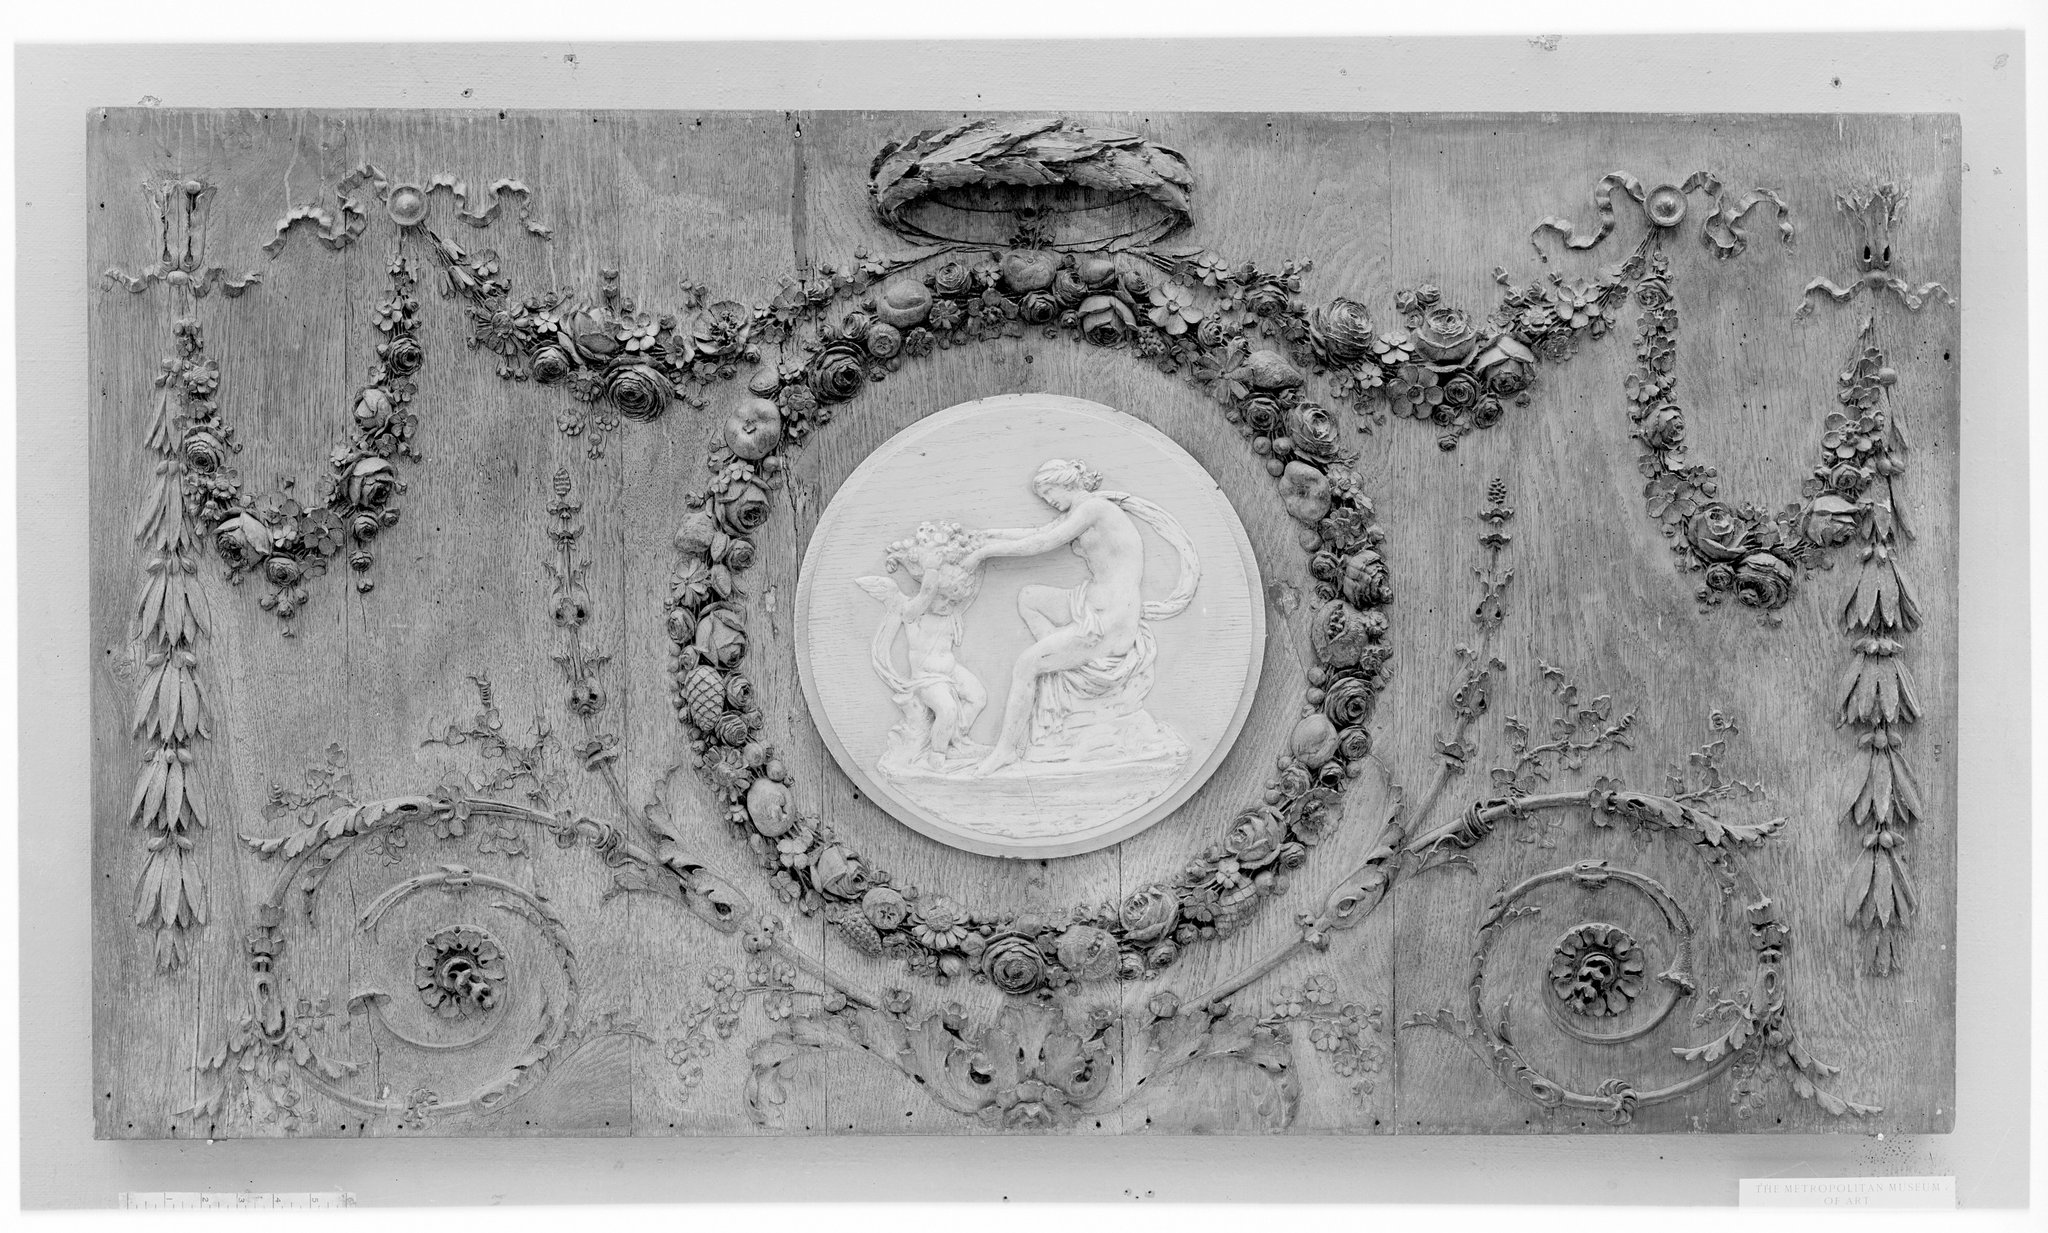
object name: panel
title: Panel (Dessus de porte)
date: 1701-1800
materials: wood, wax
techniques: painting, polish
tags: garlands,female nudes